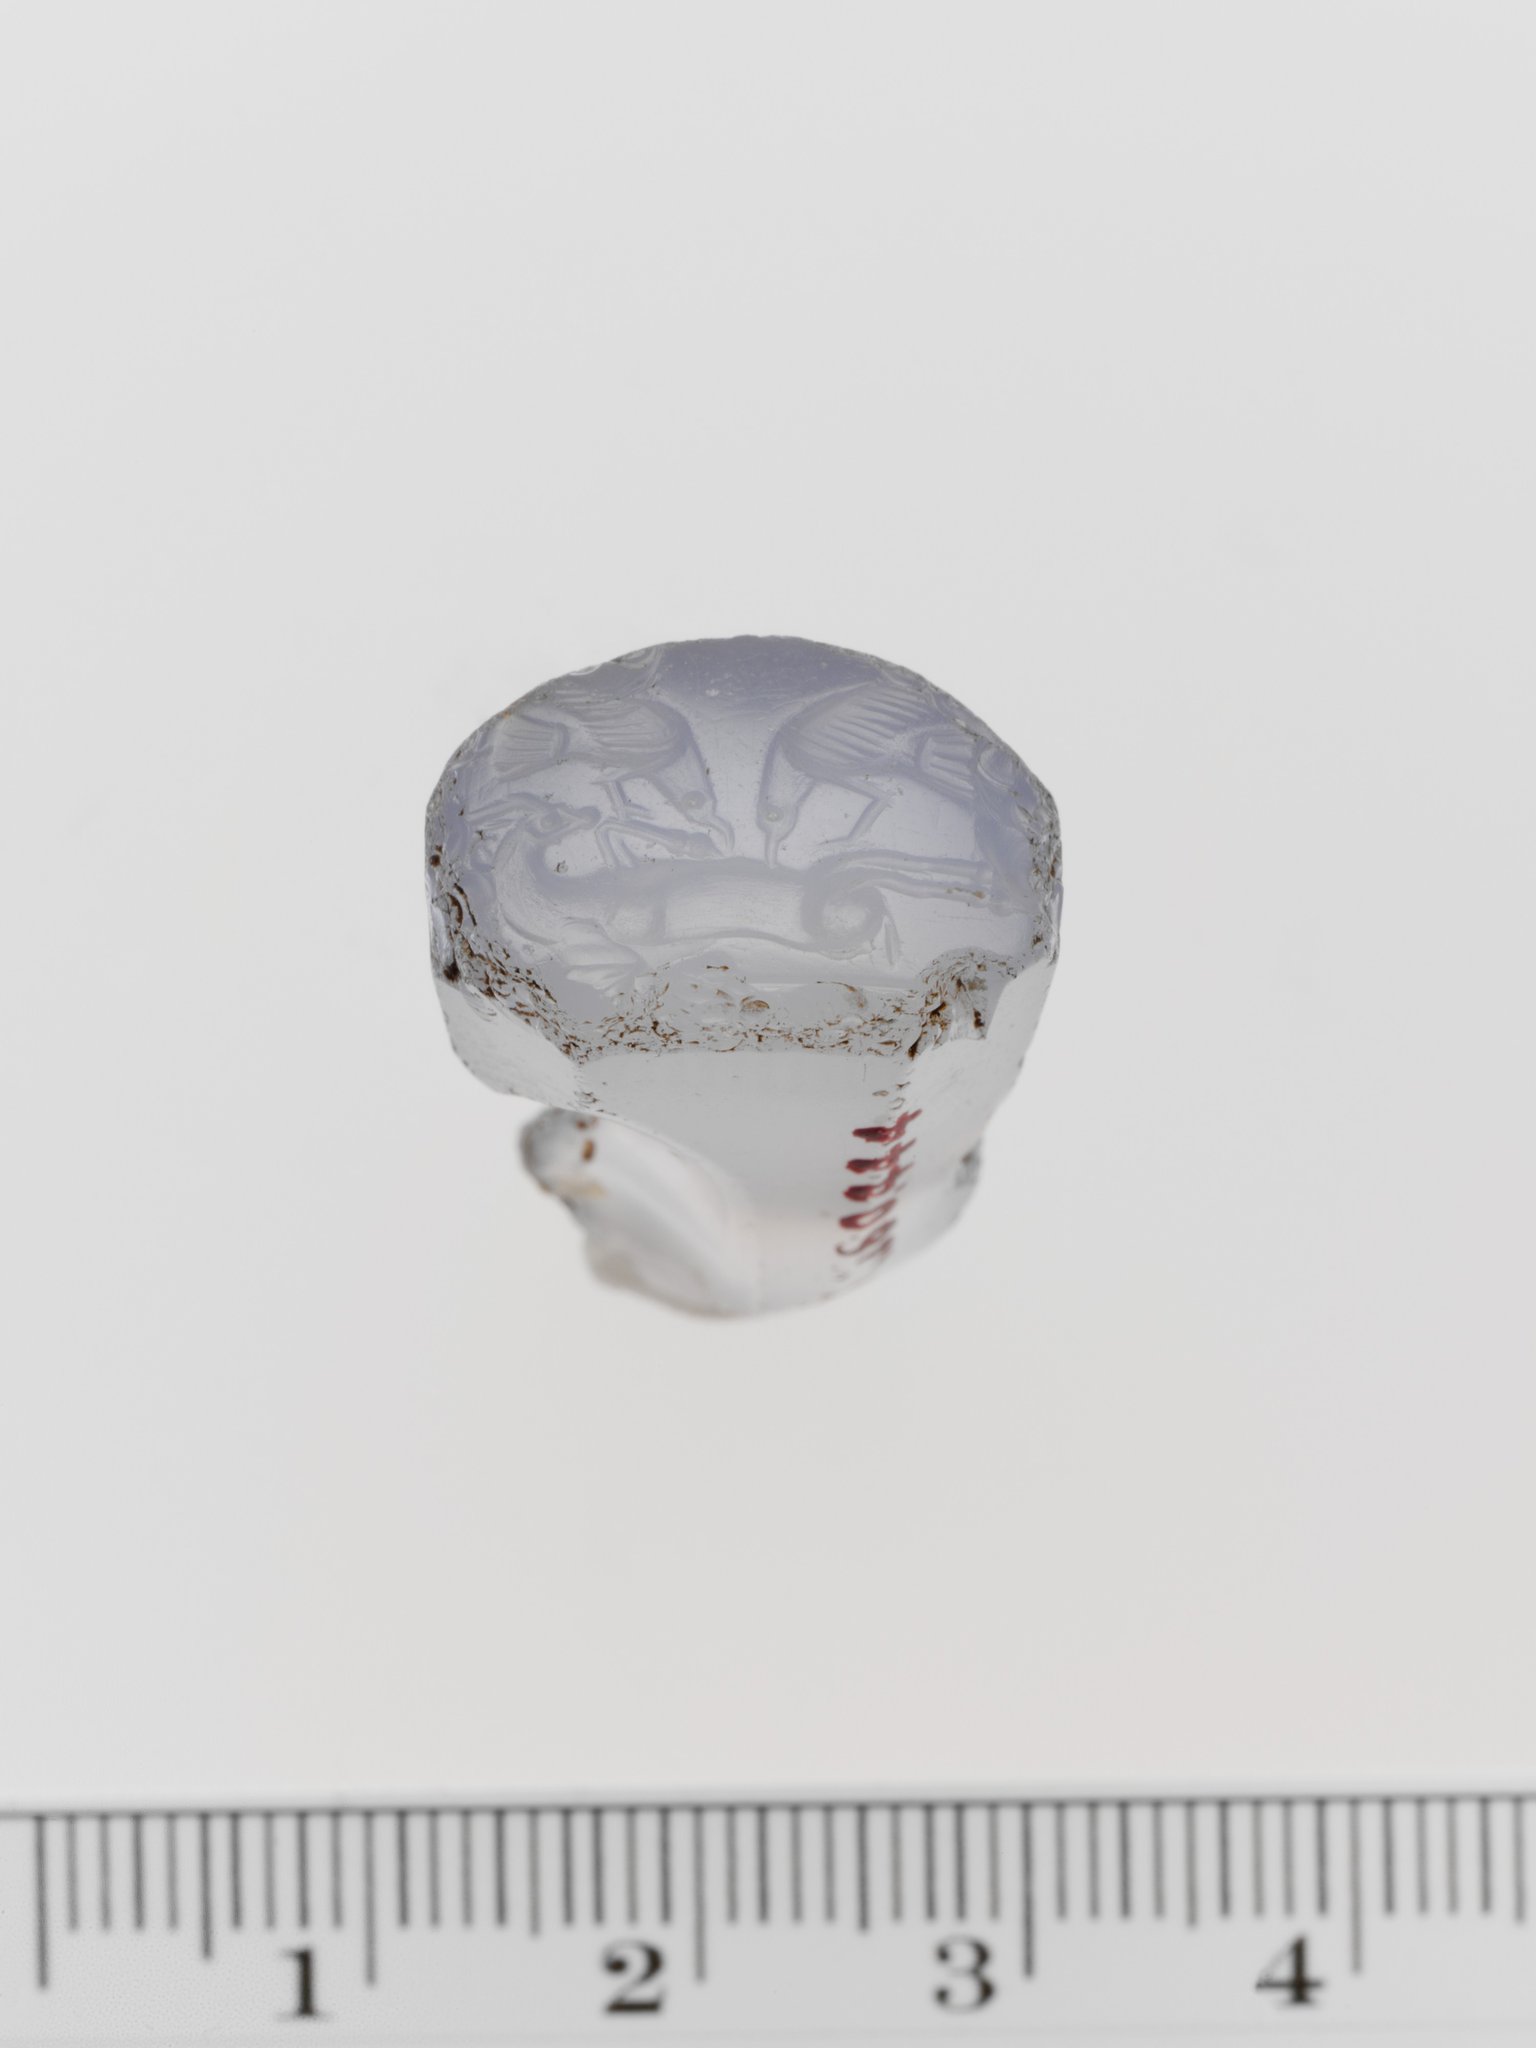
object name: seal, conoid, or pendant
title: Chalcedony eight-sided cone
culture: greek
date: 500-451 BCE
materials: stone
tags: birds,deer